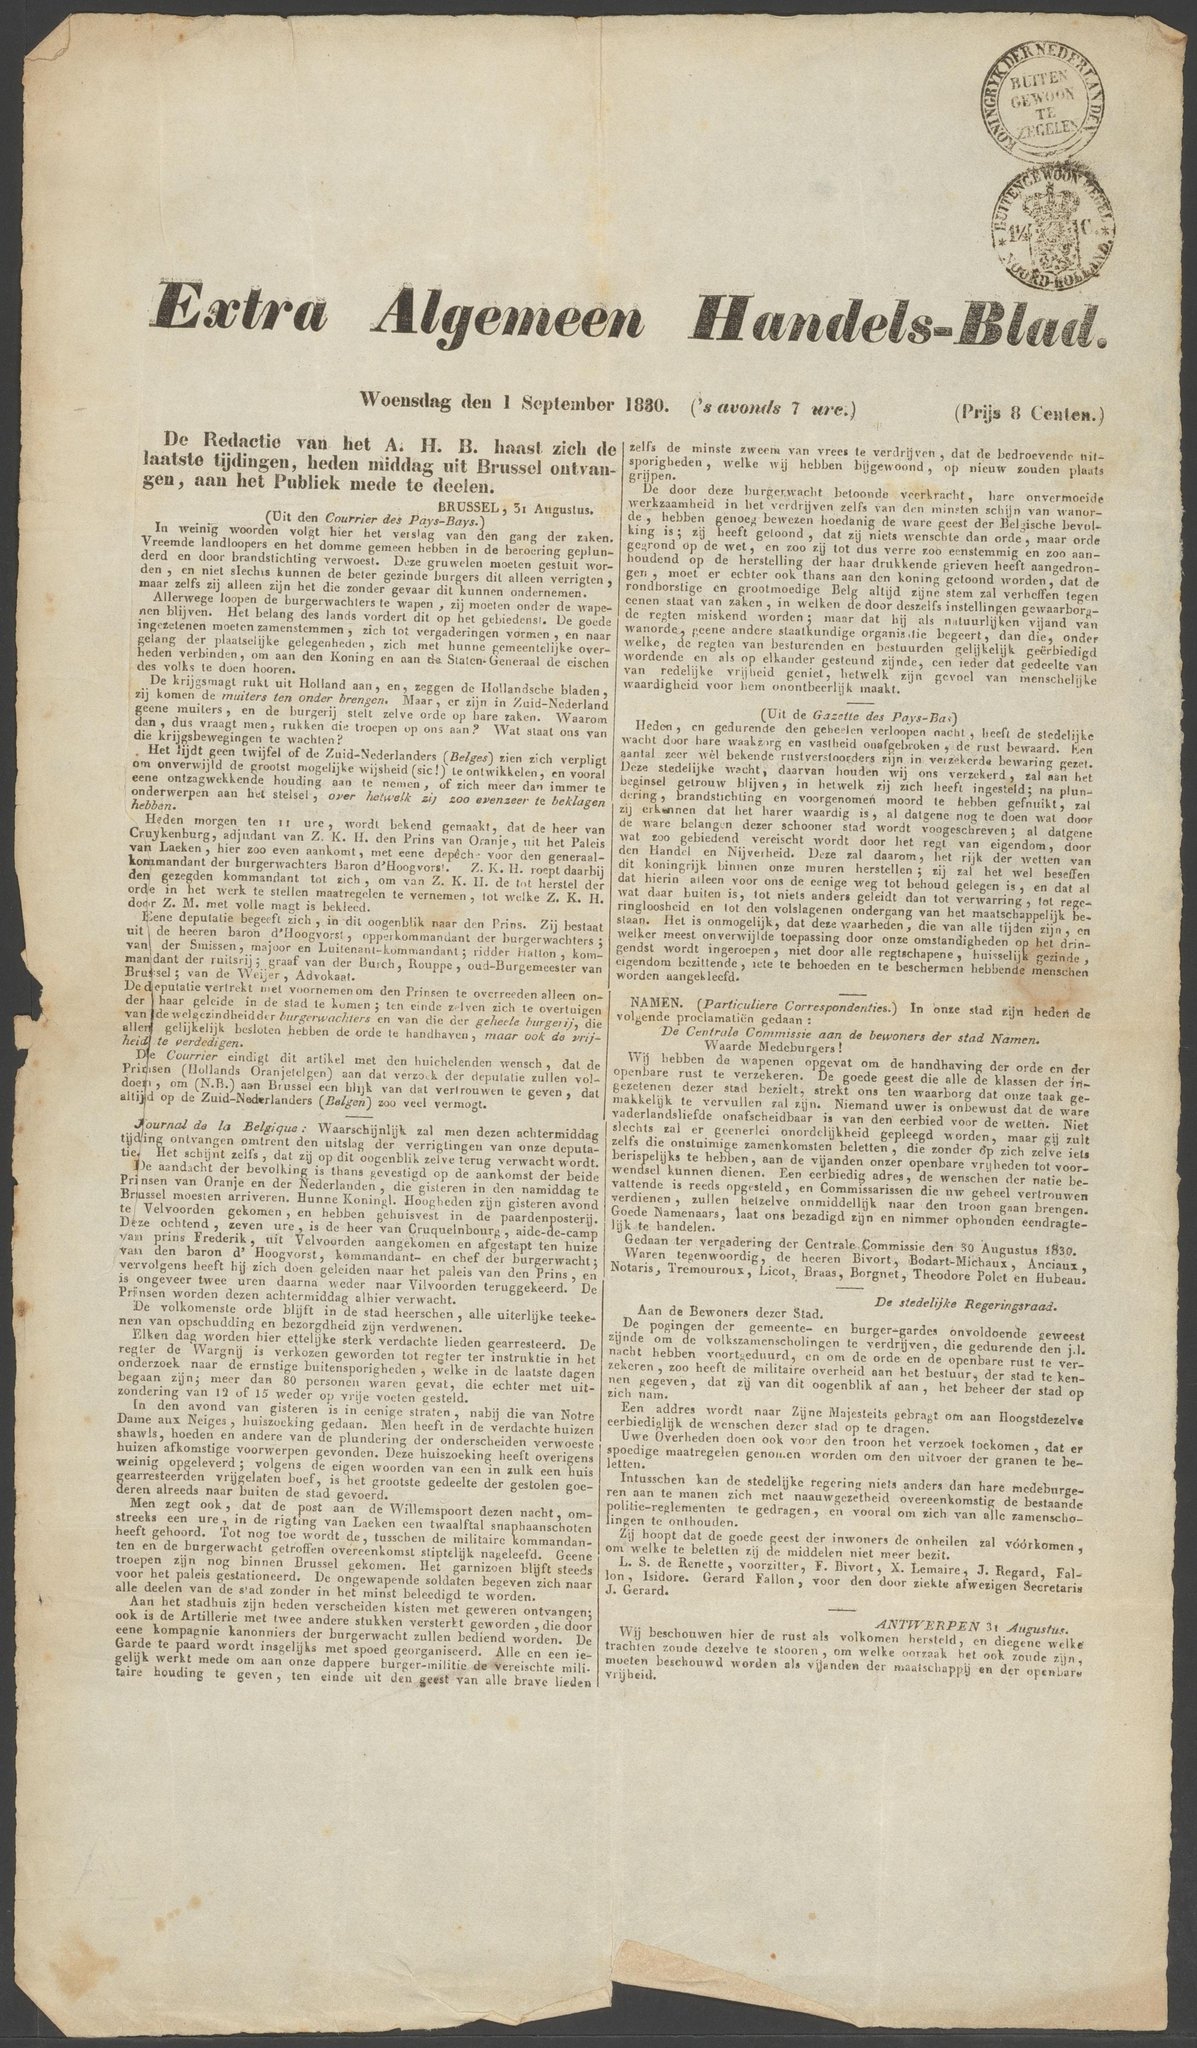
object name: newspaper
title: Extra Algemeen Handels-Blad, 1 september 1830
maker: Anonymous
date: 1830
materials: paper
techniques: letterpress printing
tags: newspaper, news-sheet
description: Exemplaar van de krant 'Extra Algemeen Handels-Blad' van 1 september 1830. Enkelbladig, één zijde bedrukt. Rechtsboven twee stempels betaalde accijnzen. Onderwerpsrubrieken binnen de Atlas Zeden en Gewoonten: Regeering, Officieele Nieuwsbladen.